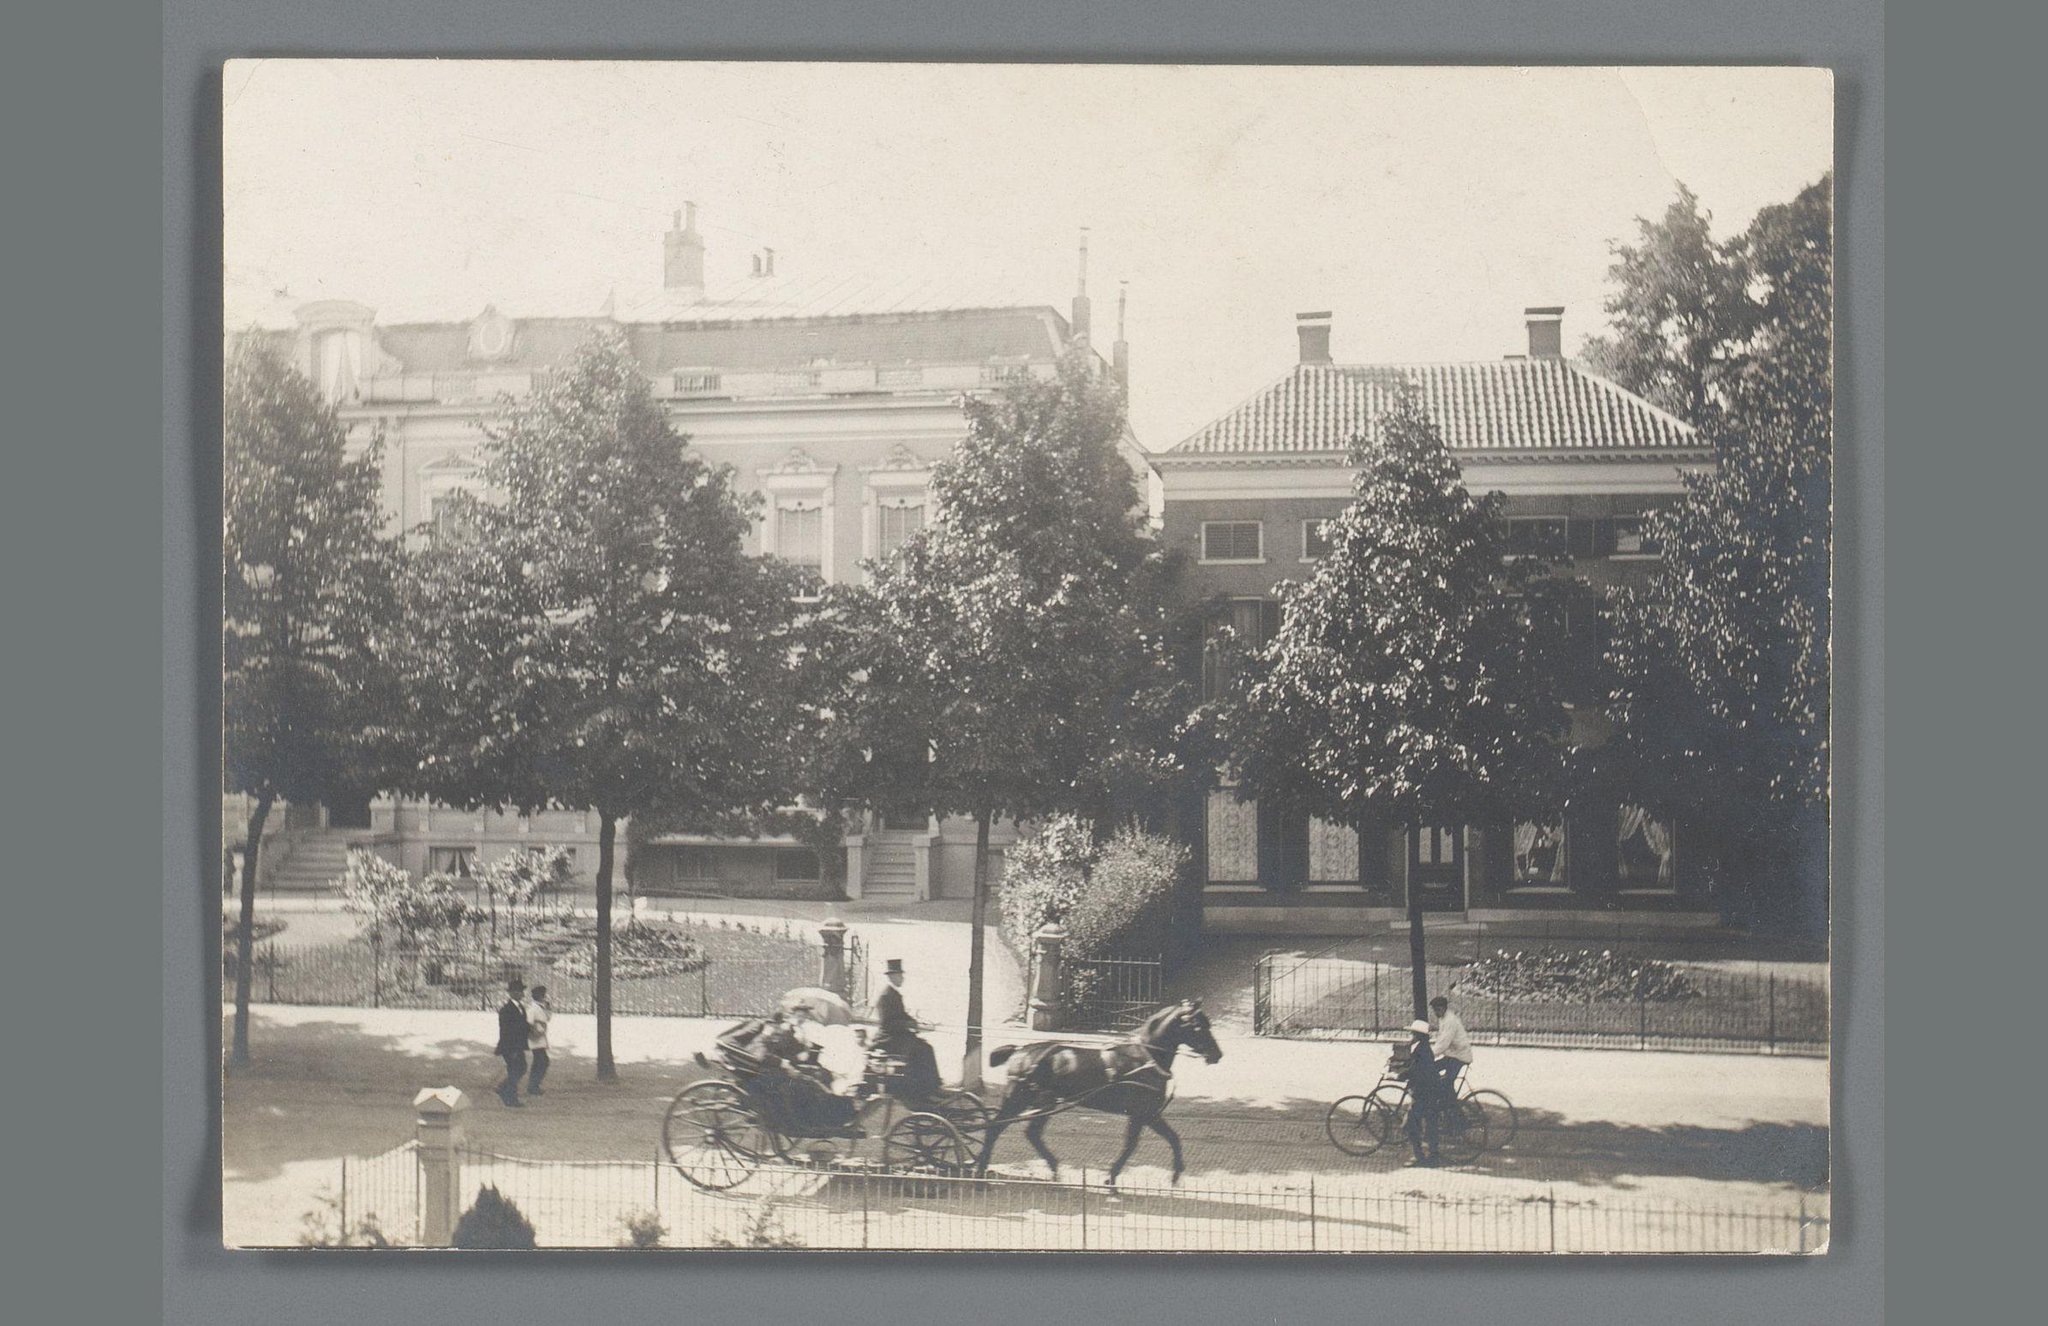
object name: photograph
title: Paardenkoets, vermoedelijk de dokterskoets van Piet de Jong, fietsers en wandelaars op straat in Arnhem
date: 1895-1918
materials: paper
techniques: gelatin silver print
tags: four-wheeled vehicle drawn by one animal, riding, cycling (recreation), walking, arnhem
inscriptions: inscription: ‘Arnhem’